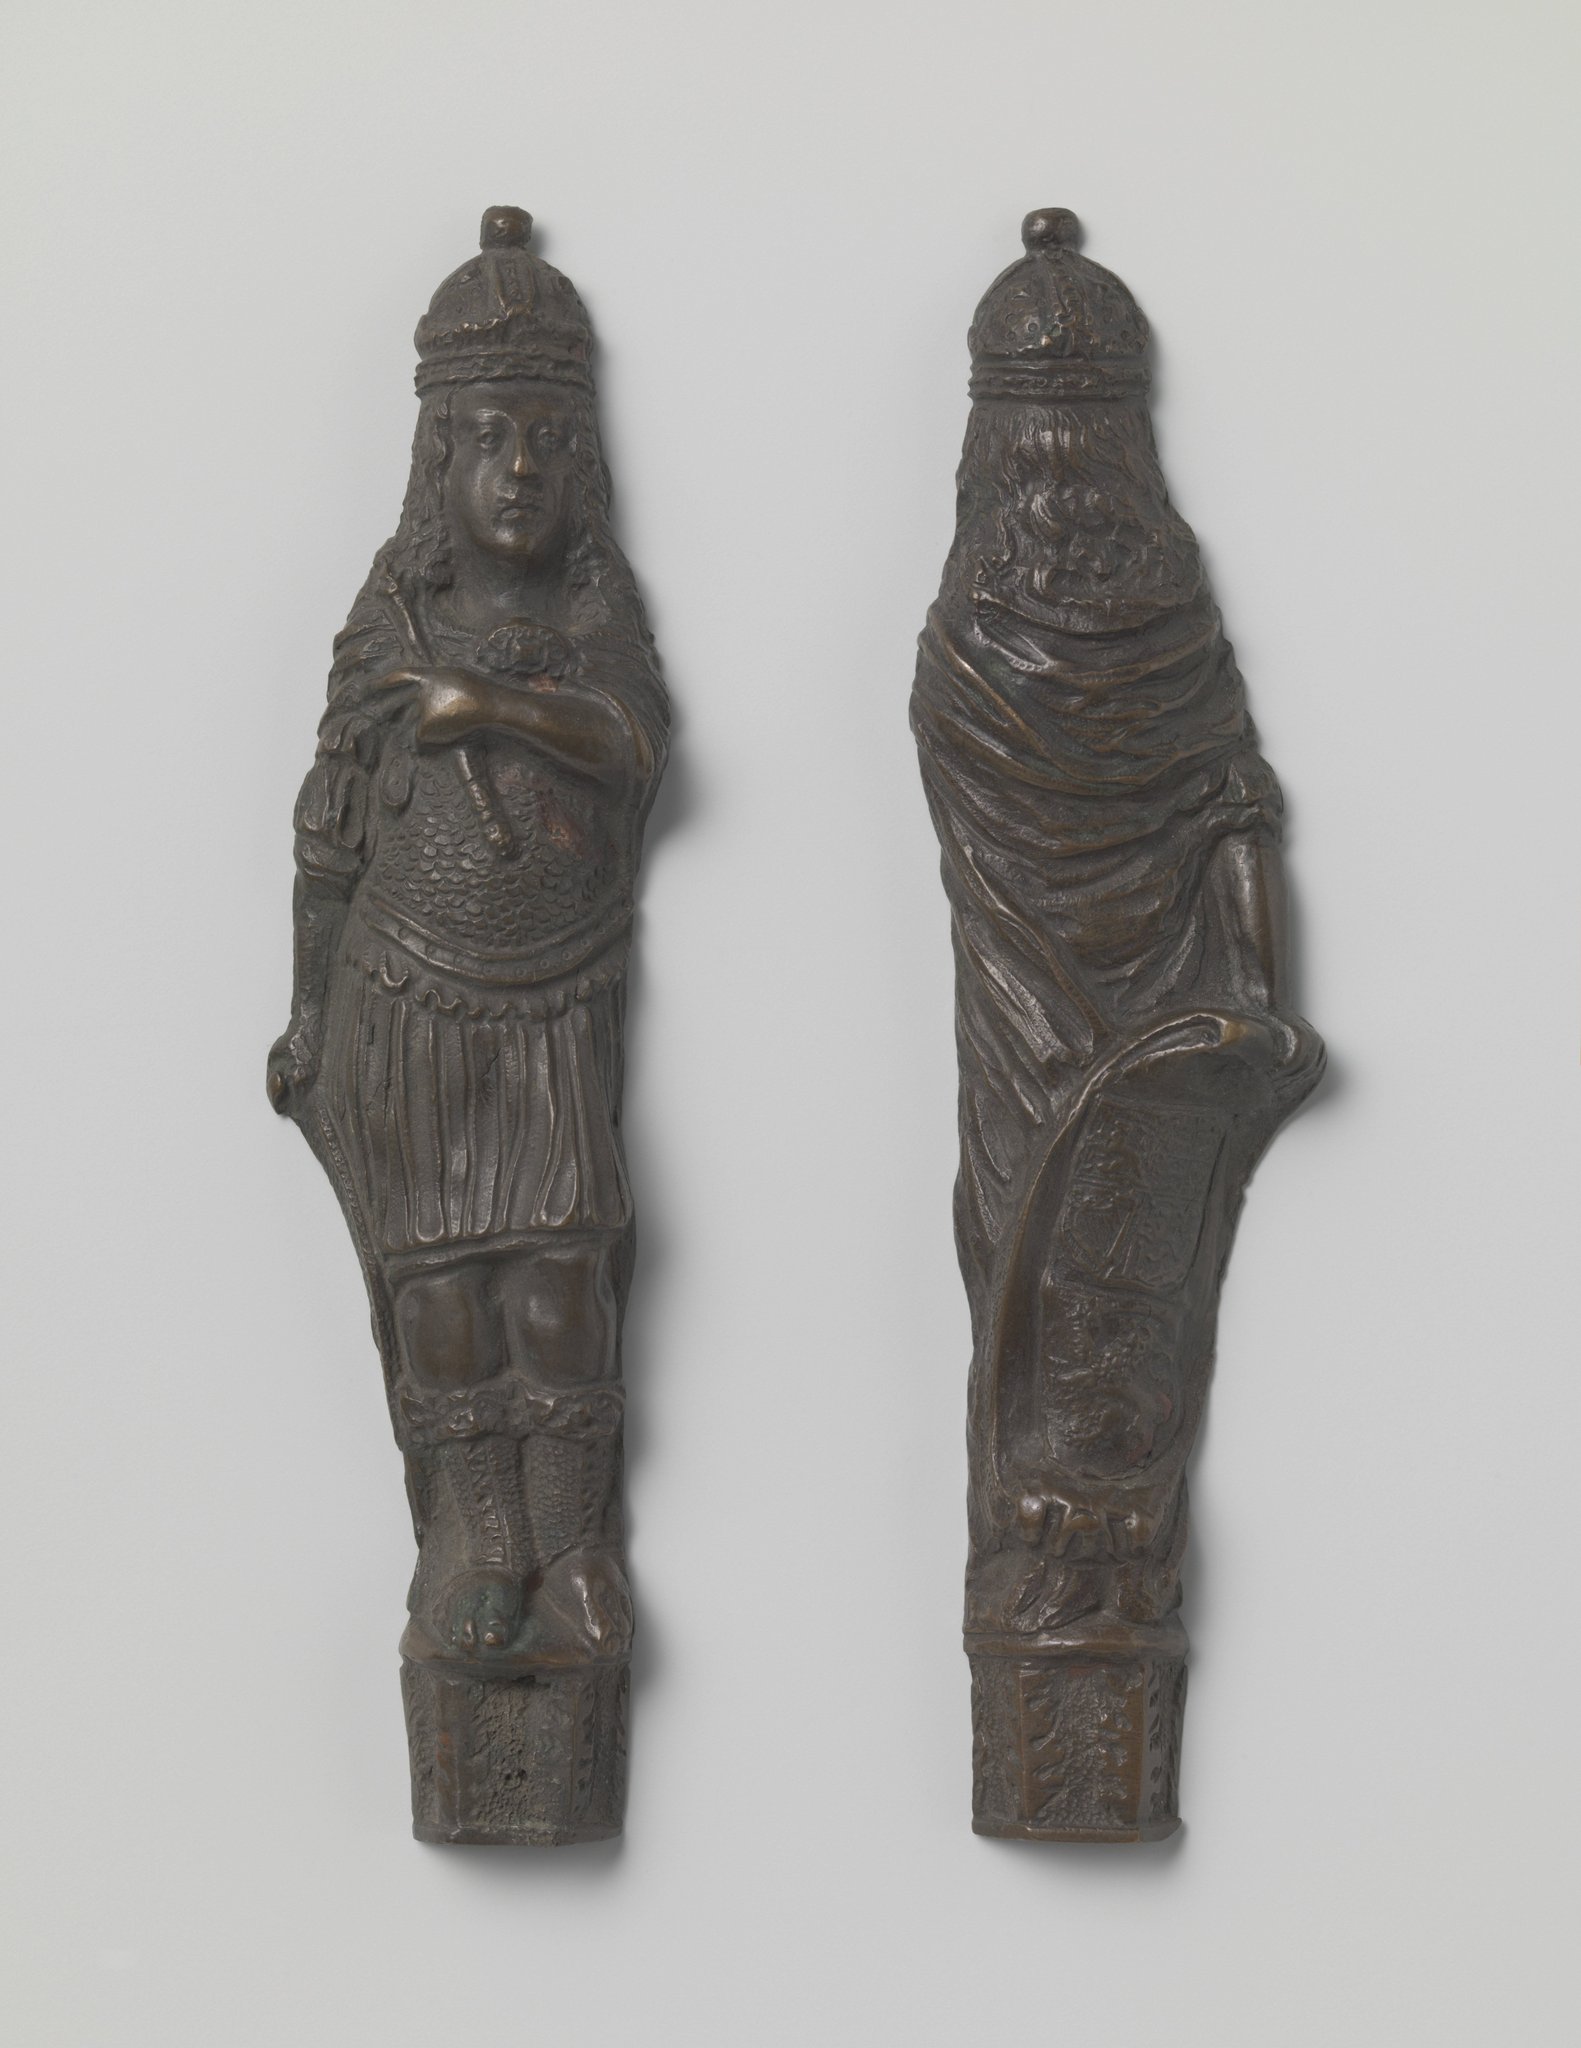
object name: knife handle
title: Messenheft met de figuur van koning Willem III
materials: copper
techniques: casting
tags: the hague, william iii (prince of orange and king of england, scotland, and ireland), england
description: Willem III werd op 12 februari 1689 tot koning van Engeland en op 14 maart 1689 tot koning van Schotland uitgeroepen. De kroning vond plaats op 11 april 1689. Blijkens het eerste wapen is hij als koning van Schotland weergegeven. De Leo Belgicus is weergegeven met een zwaar i.p.v. zeven pijlen. Vermoedelijk is dit voorwerp een onderdeel van een stel geweest, waarbij het heft van de vork de figuur van Maria Stuart (1662-1695), gemalin van Willem III uitbeeldde.